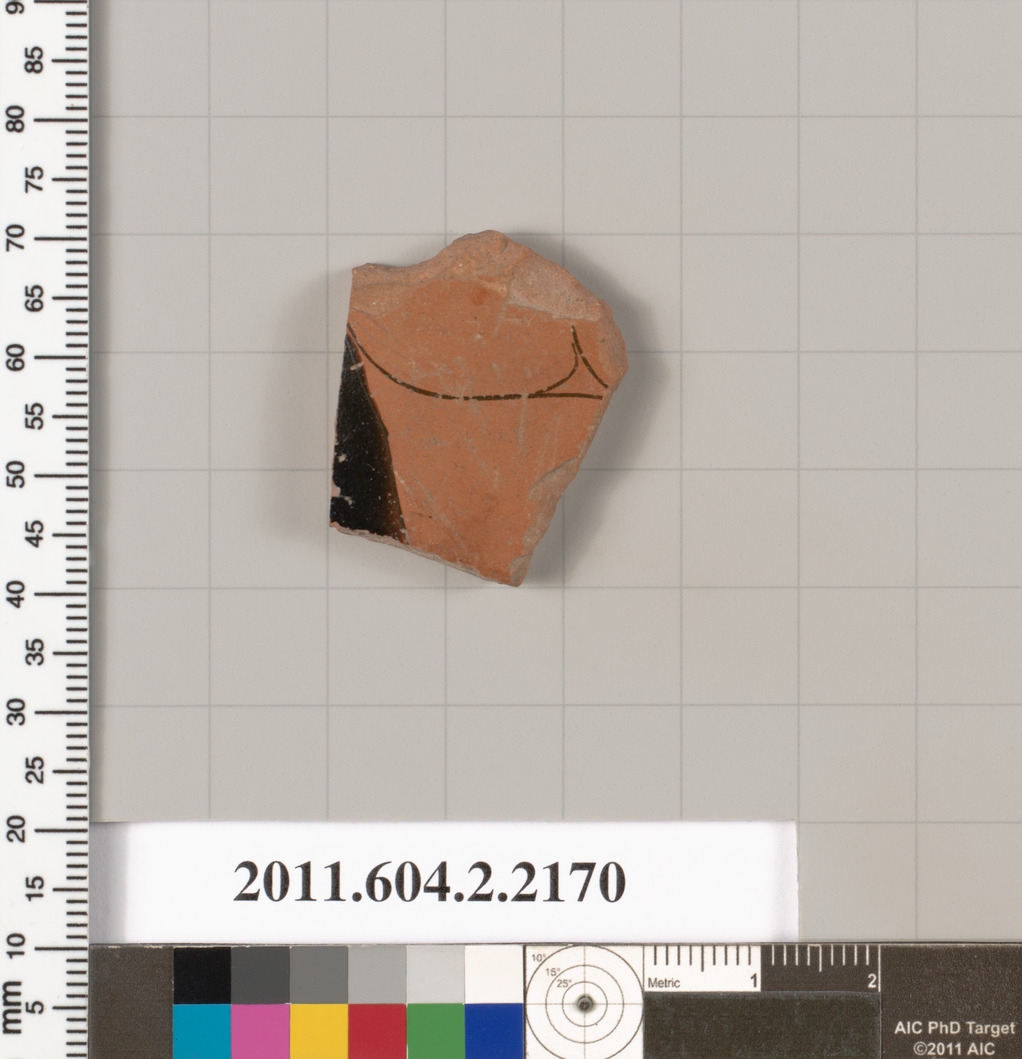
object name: pot fragment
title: Terracotta fragment of a pot; unglazed on the inside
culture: greek, attic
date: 500-480 BCE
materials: terracotta